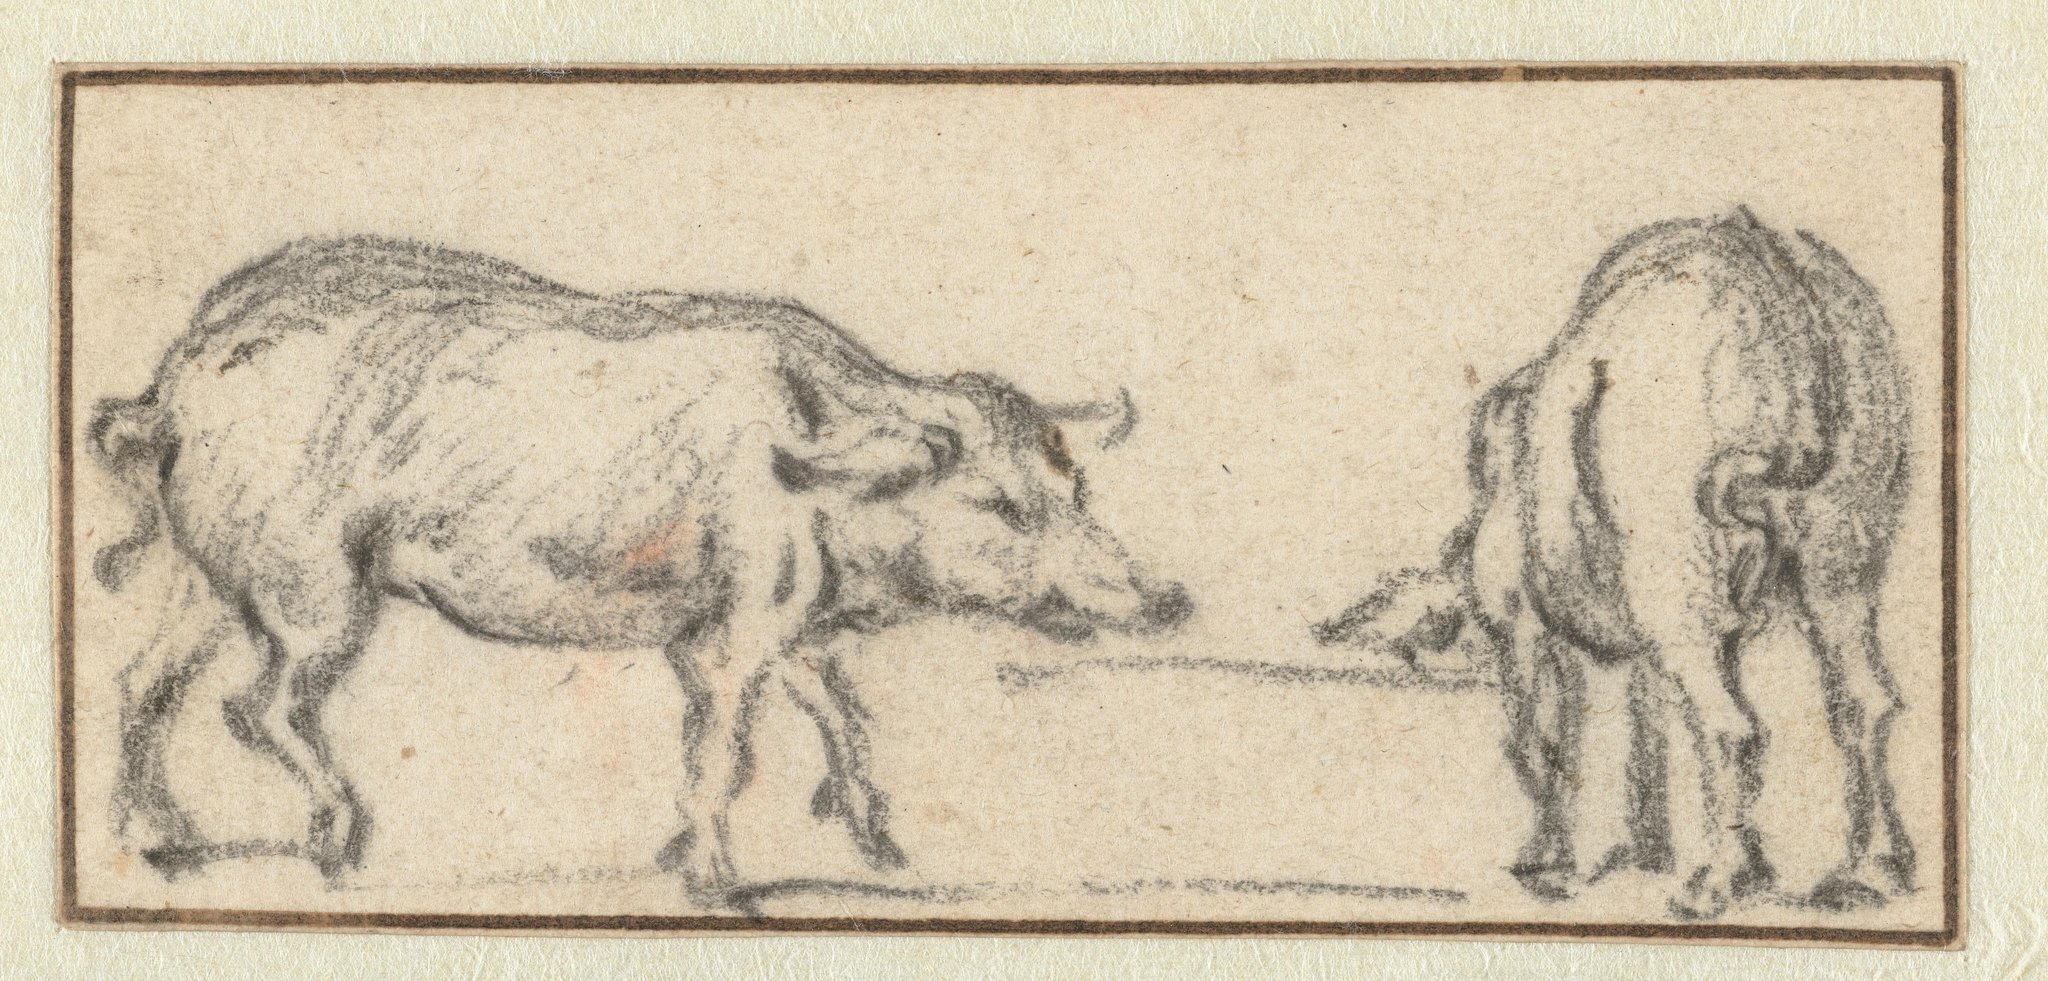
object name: drawing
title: Twee varkens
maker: karel du jardin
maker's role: draughtsman, painter, print maker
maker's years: 1626-1678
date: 1632-1678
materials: chalk, paper